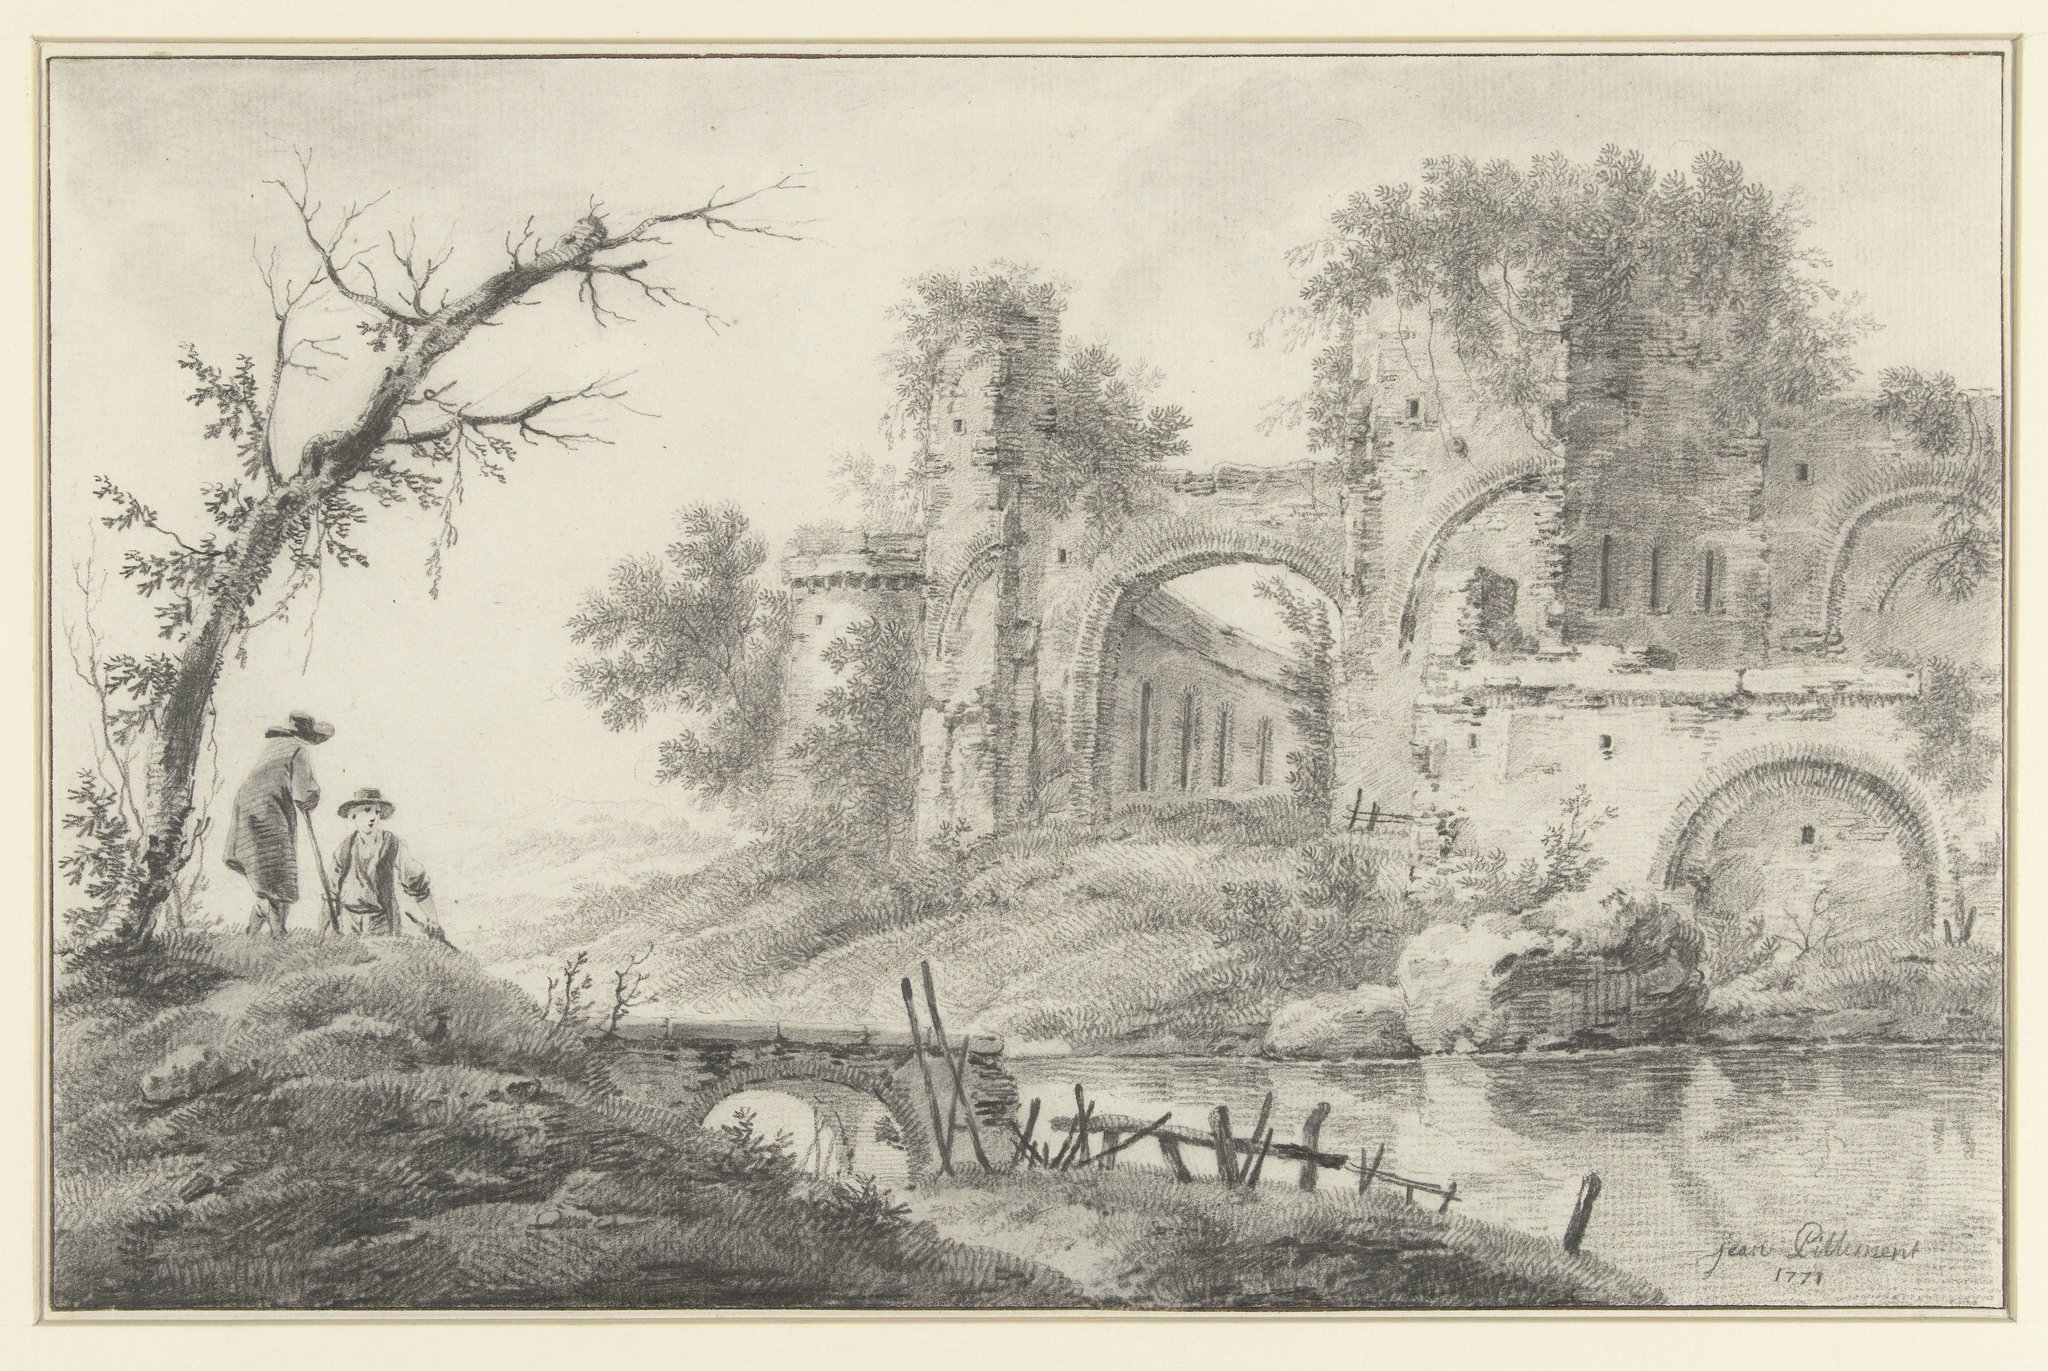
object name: drawing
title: Ruïne aan een rivier met twee landlieden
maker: jean baptiste pillement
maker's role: designer, draughtsman, print maker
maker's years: 1728-1808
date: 1771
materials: chalk, paper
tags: landscape with ruins, river (+ landscape with figures, staffage)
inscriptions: signature and date, recto, lower right, black chalk: ‘Jean Pillement // 1771’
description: Ruïne aan een rivier; links bij een afgebrokkelde brug twee landlieden.